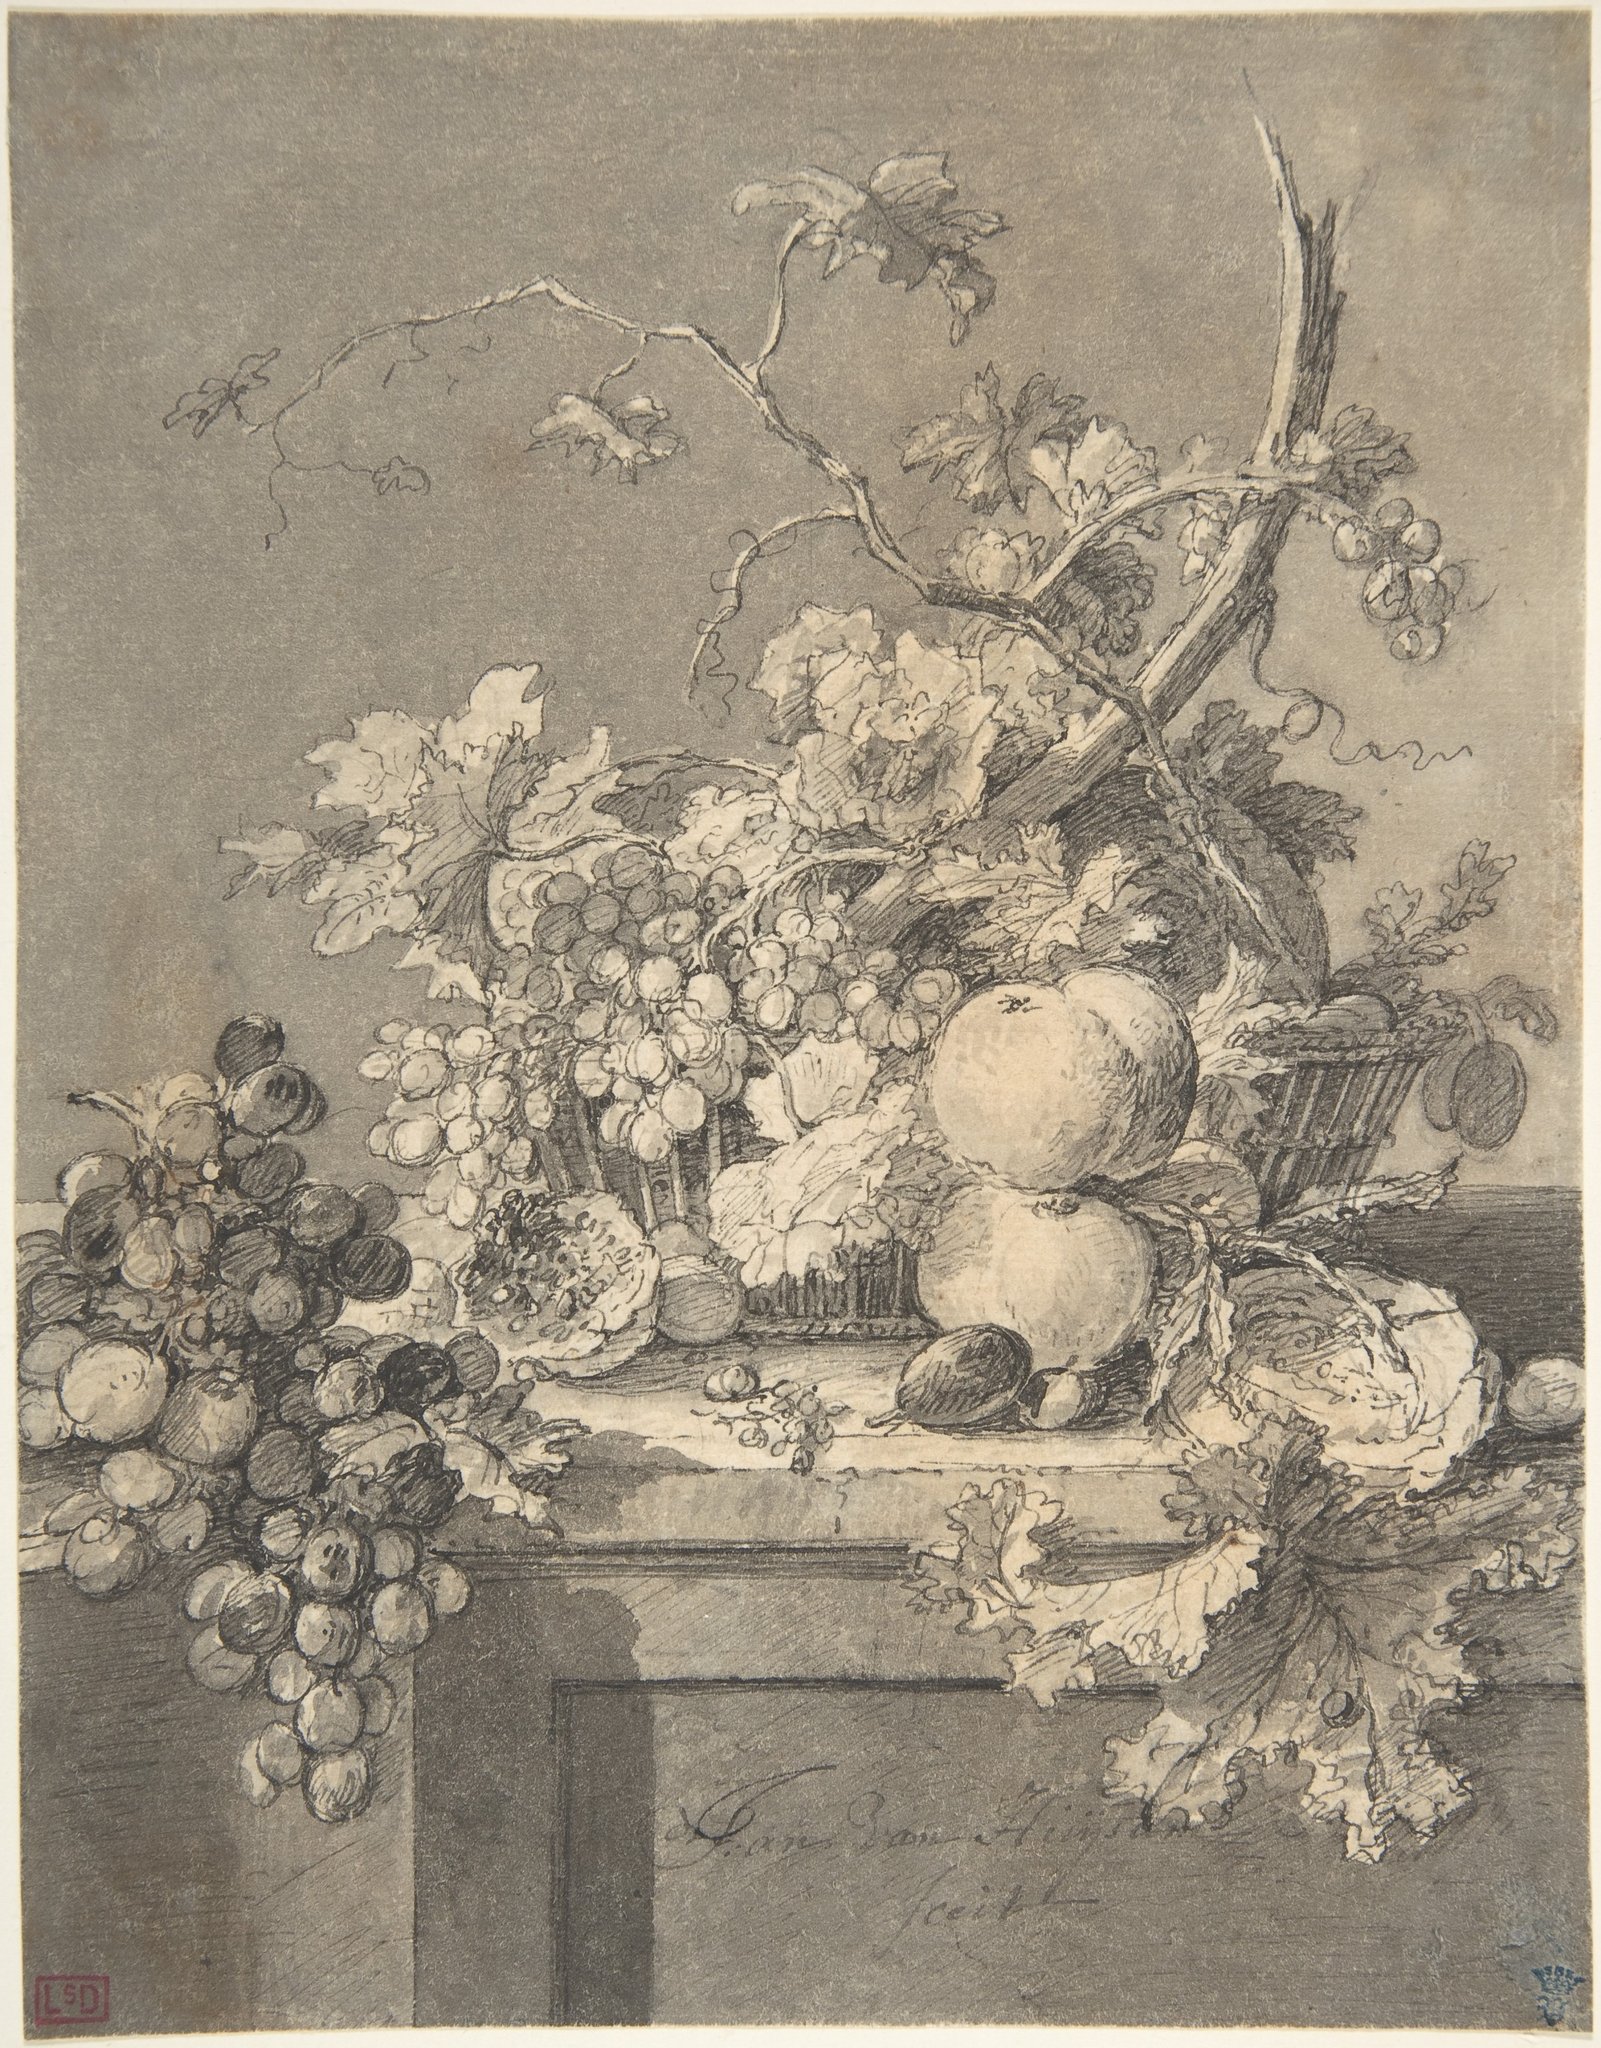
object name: drawing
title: A Basket of Fruit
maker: jan van huysum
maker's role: artist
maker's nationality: dutch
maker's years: 1682-1749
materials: ink, paper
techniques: pen, wash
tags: fruit